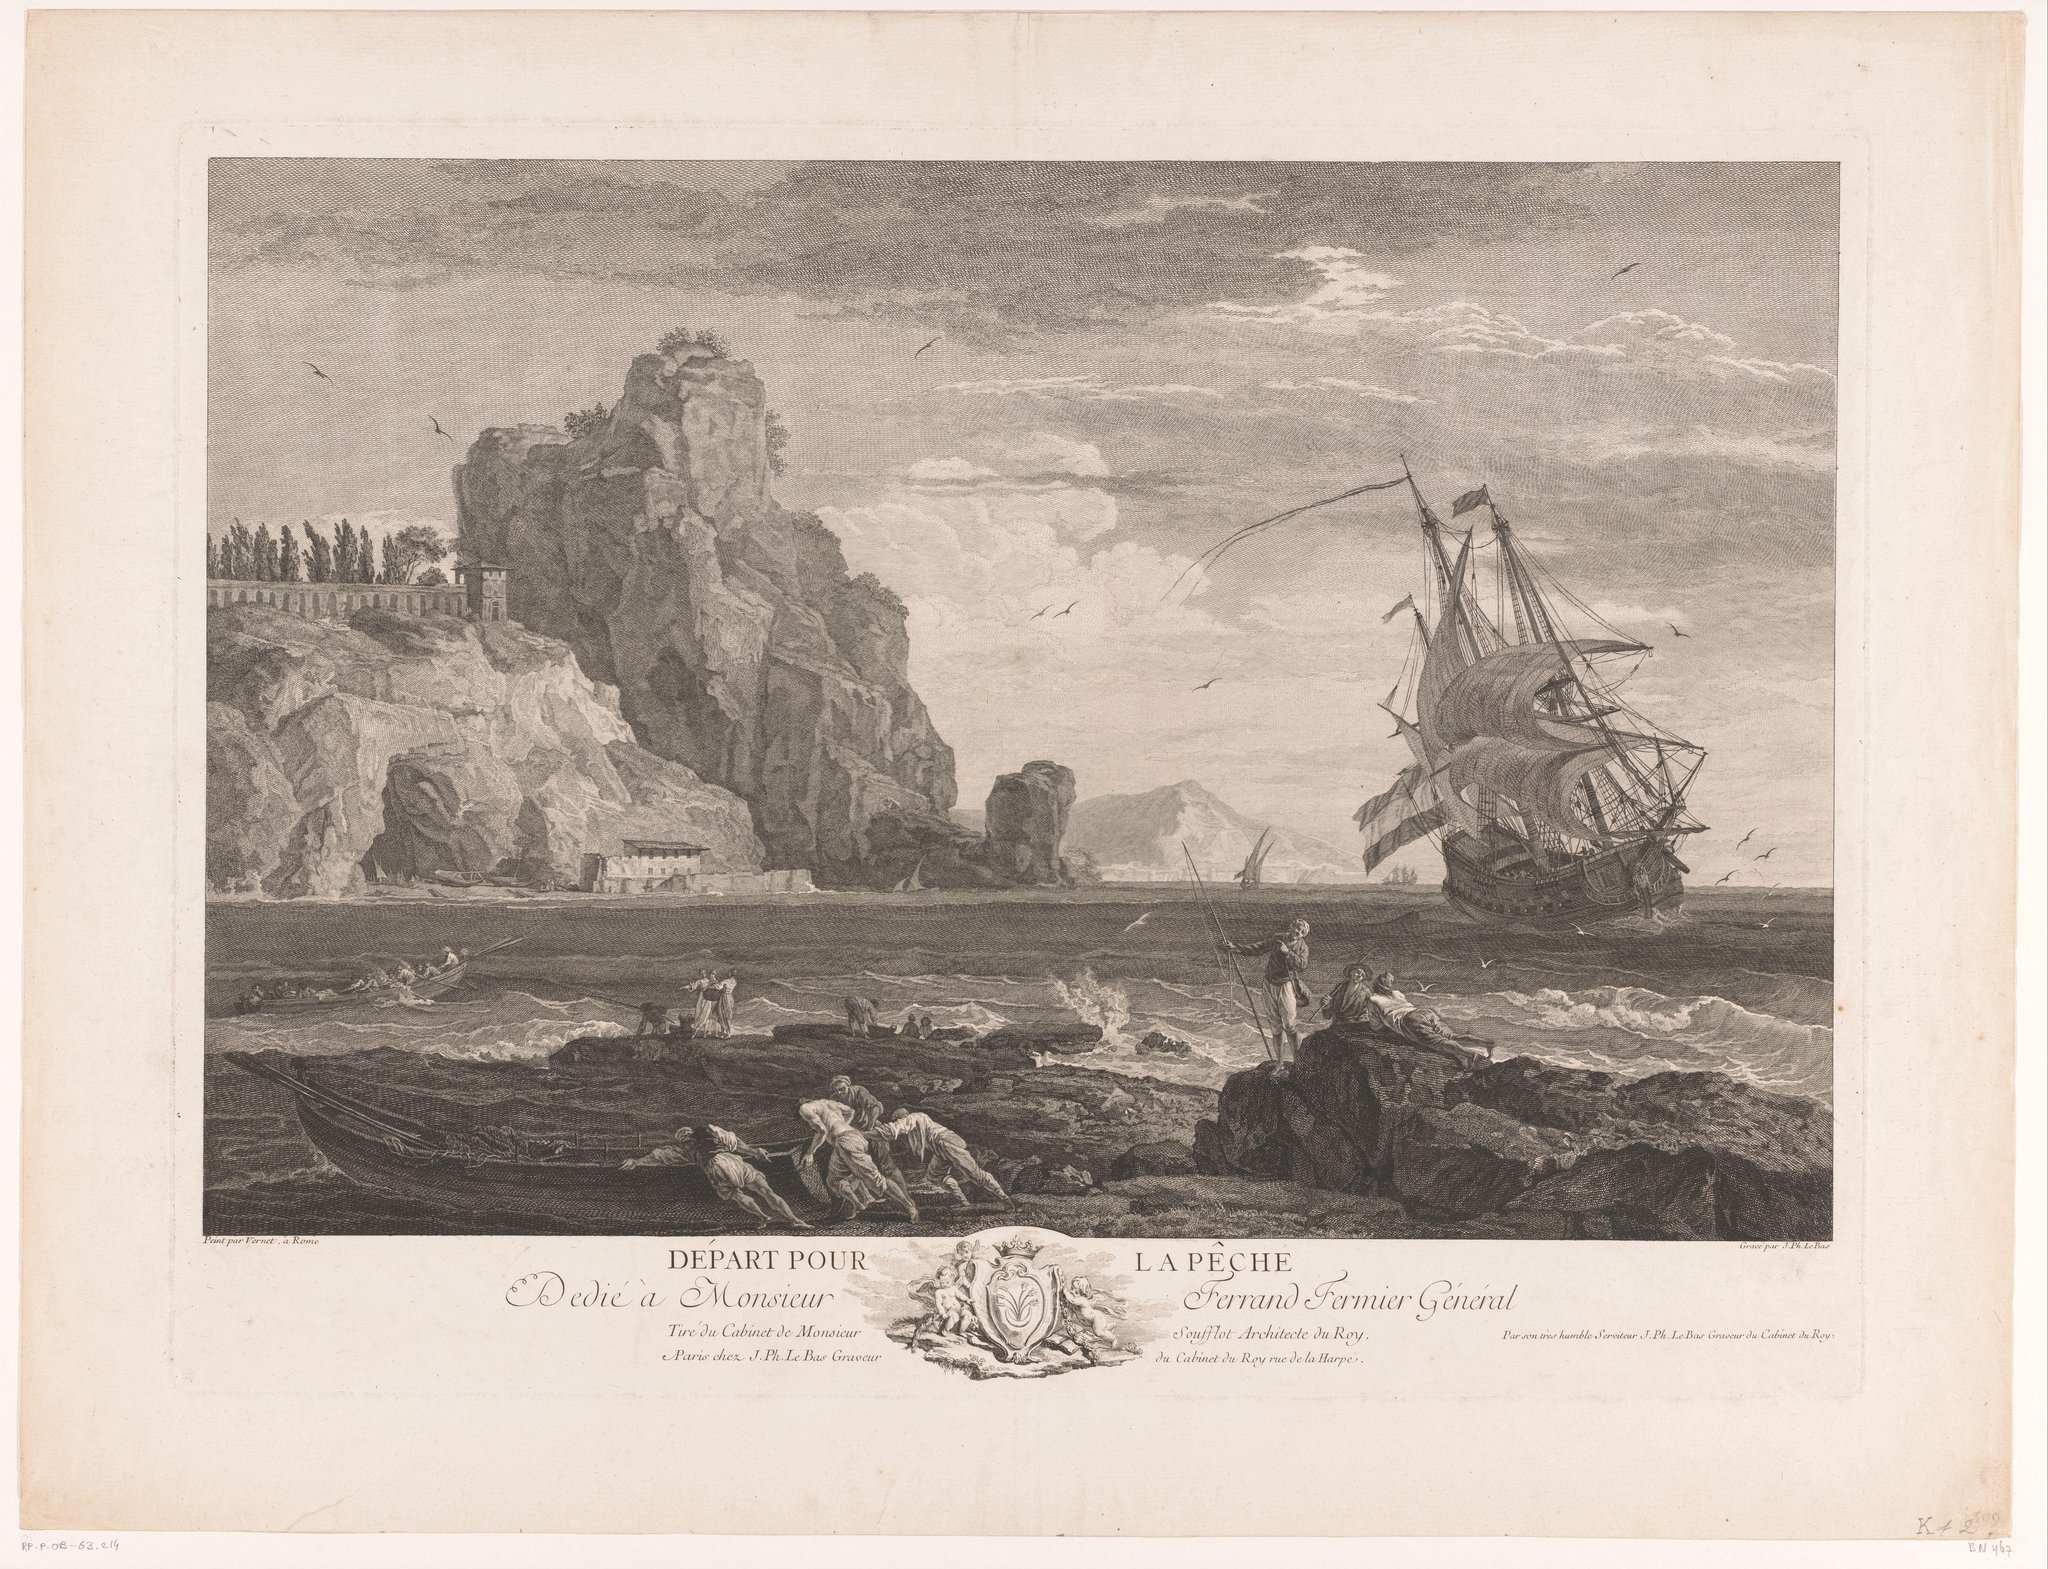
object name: print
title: Kustlandschap met vissers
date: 1750-1783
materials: paper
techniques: engraving, etching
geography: paris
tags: rocky coast, fisherman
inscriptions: collector's mark: Lugt 240